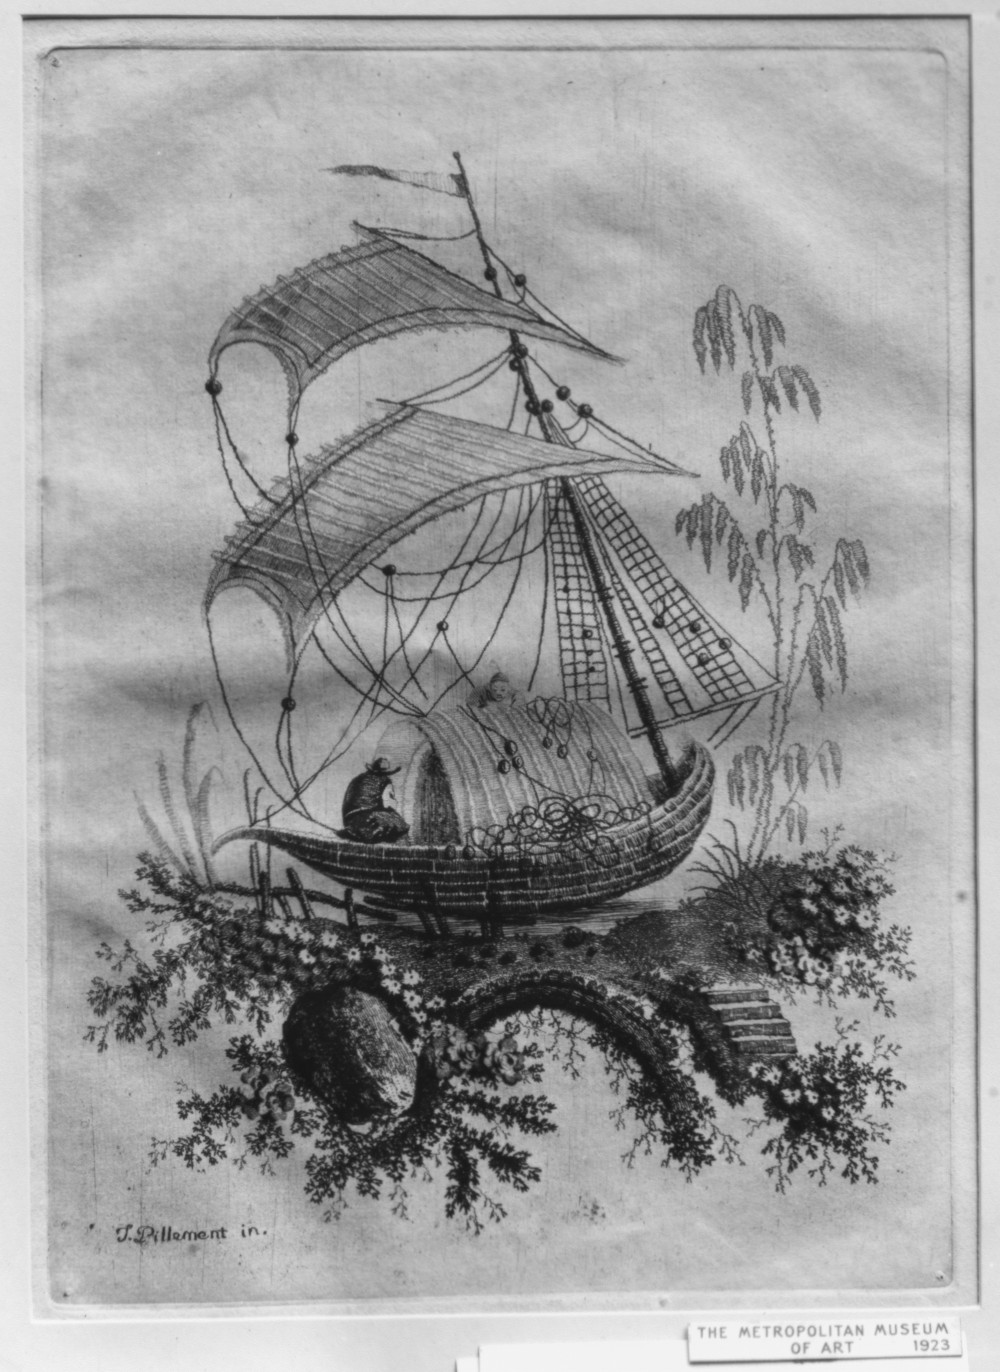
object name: print ornament architecture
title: Chinoiserie, from "Nouvelle Suite de Cahiers de dessins chinois a l'usage des dessinateurs et des peintres" (Nr 3)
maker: jean pillement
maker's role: artist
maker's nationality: french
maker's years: 1728-1808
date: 1790-1799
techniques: etching, lithography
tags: chinoiserie,flowers,boats